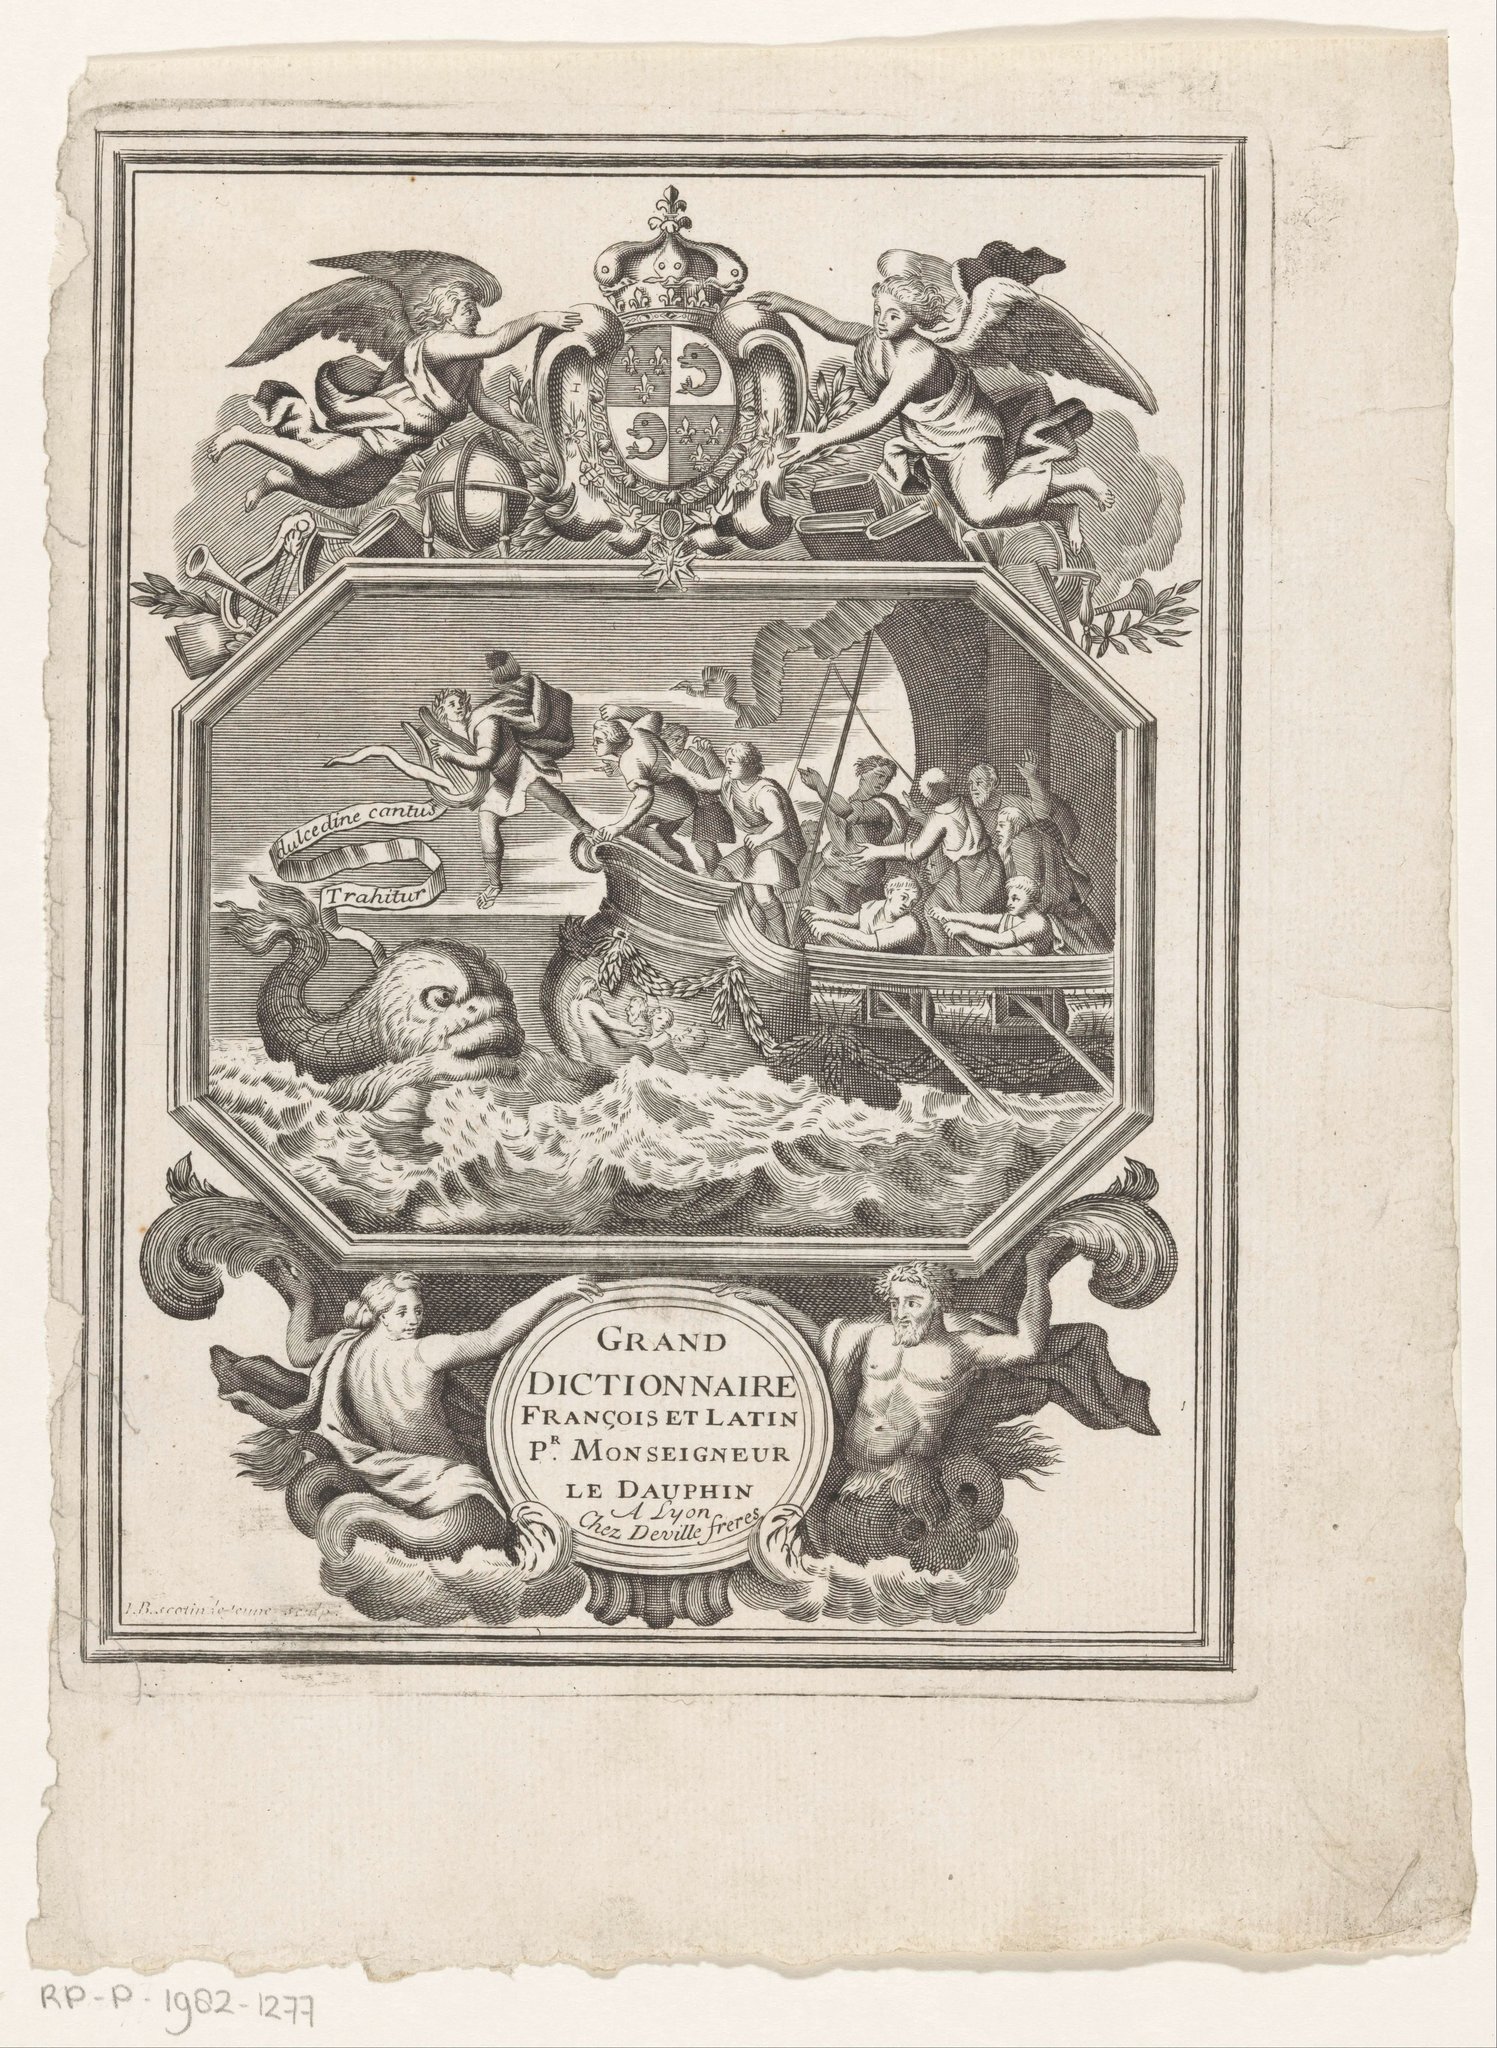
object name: titelblad, titelpagina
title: Titelpagina voor: Pierre Danet, Grand Dictionnaire François et Latin, 1728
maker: gérard jean baptiste scotin (ii)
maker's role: print maker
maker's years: 1698-1755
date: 1728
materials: paper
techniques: engraving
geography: lyon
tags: arion rides on a dolphin, holding his lyre, (story of) arion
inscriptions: collector's mark: Lugt 2760, collector's mark: Lugt 2228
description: De zanger Arion speelt op zijn lier op het achterdek van een schip en springt aan het einde van zijn lied overboord. Links in zee de dolfijn op wiens rug Arion verder zal reizen naar Tainaron. Boven de voorstelling twee engelen met het wapenschild van de Dauphin. Aan de onderzijde een meerman en -min aan weerszijden van de titel.